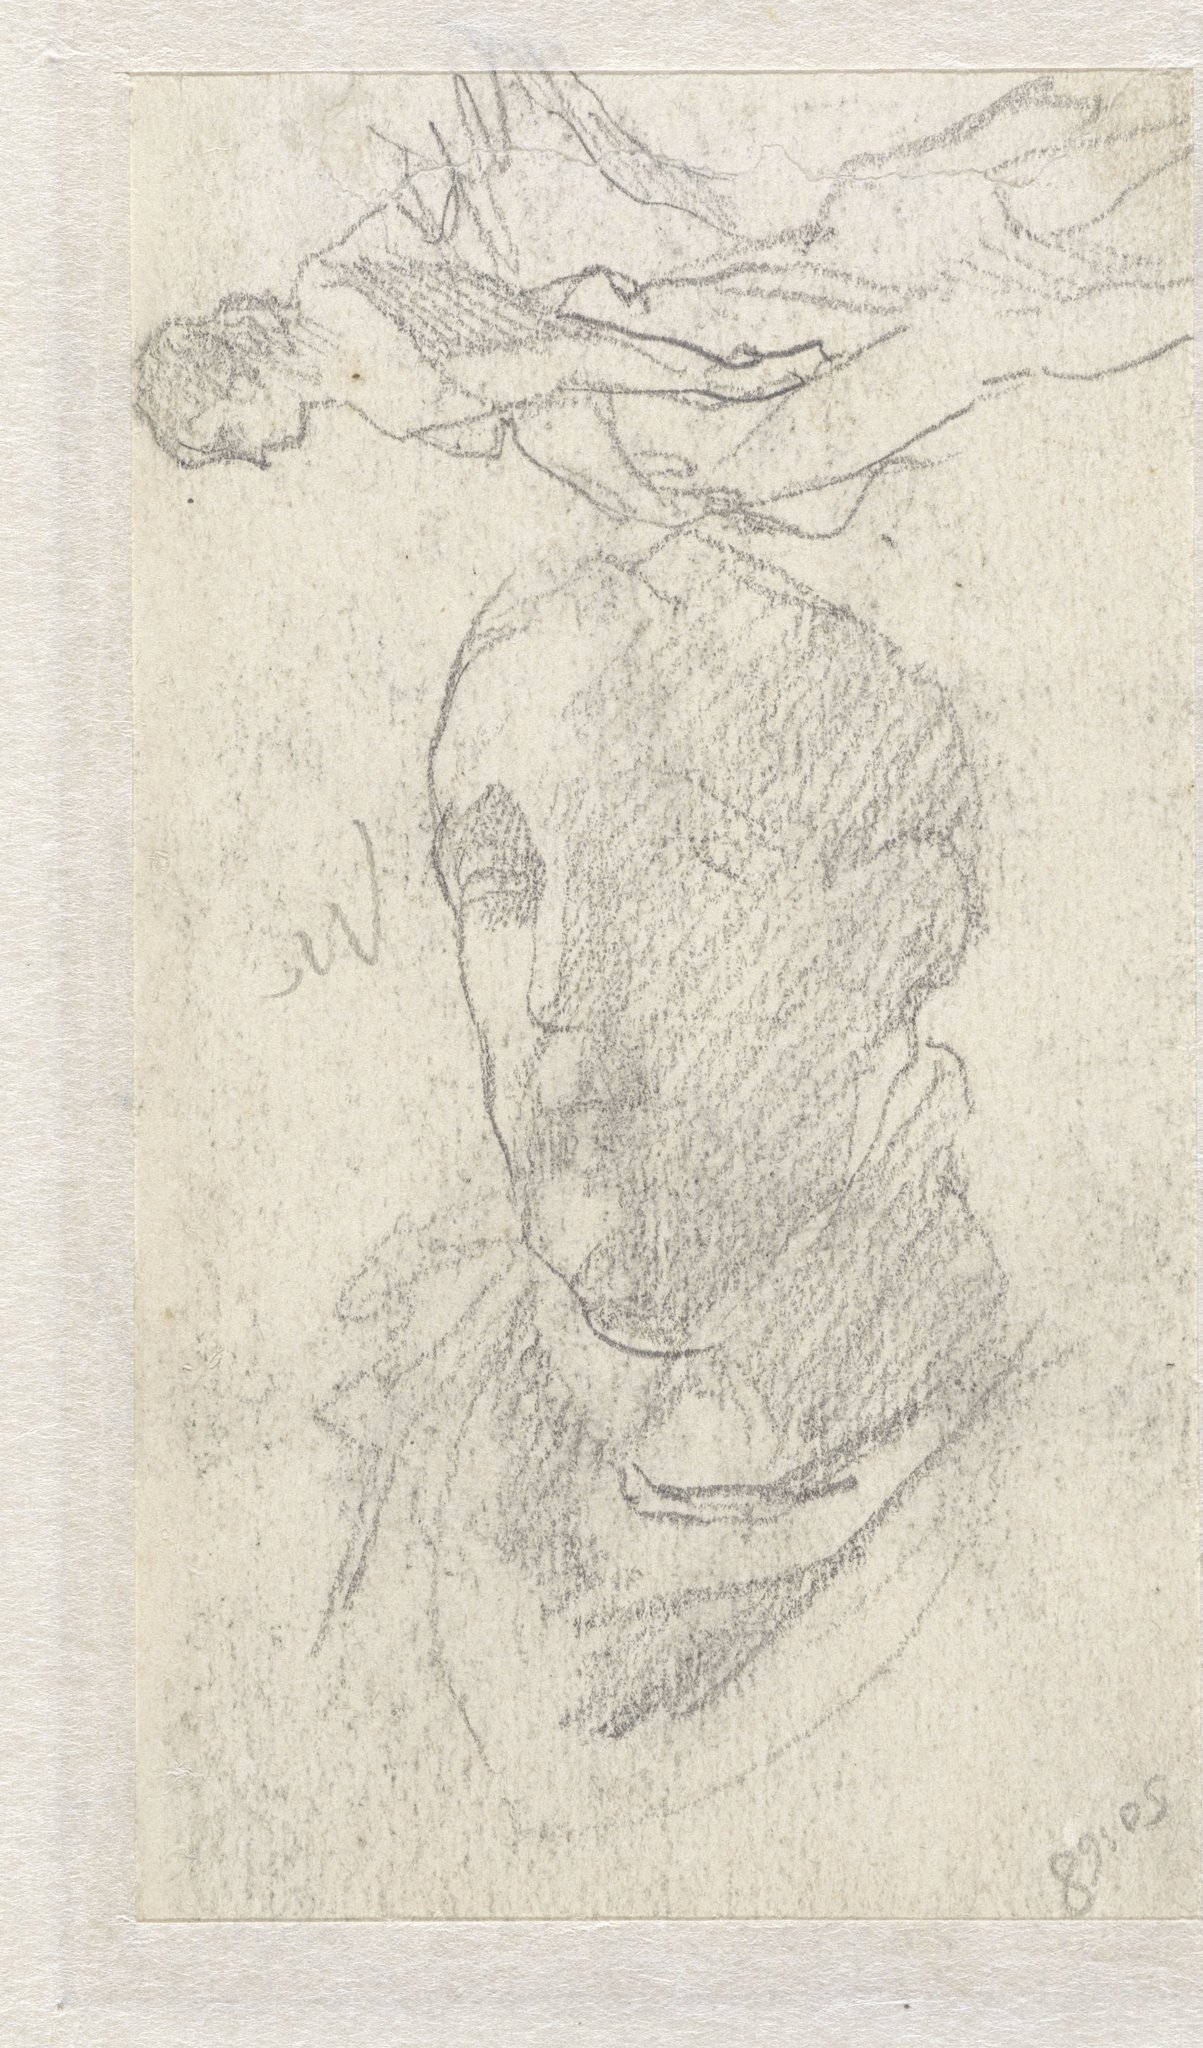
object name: drawing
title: Staande vrouw en hoofd van een man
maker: jacob maris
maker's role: draughtsman, painter, print maker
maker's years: 1837-1899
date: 1847-1899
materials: paper, pencil